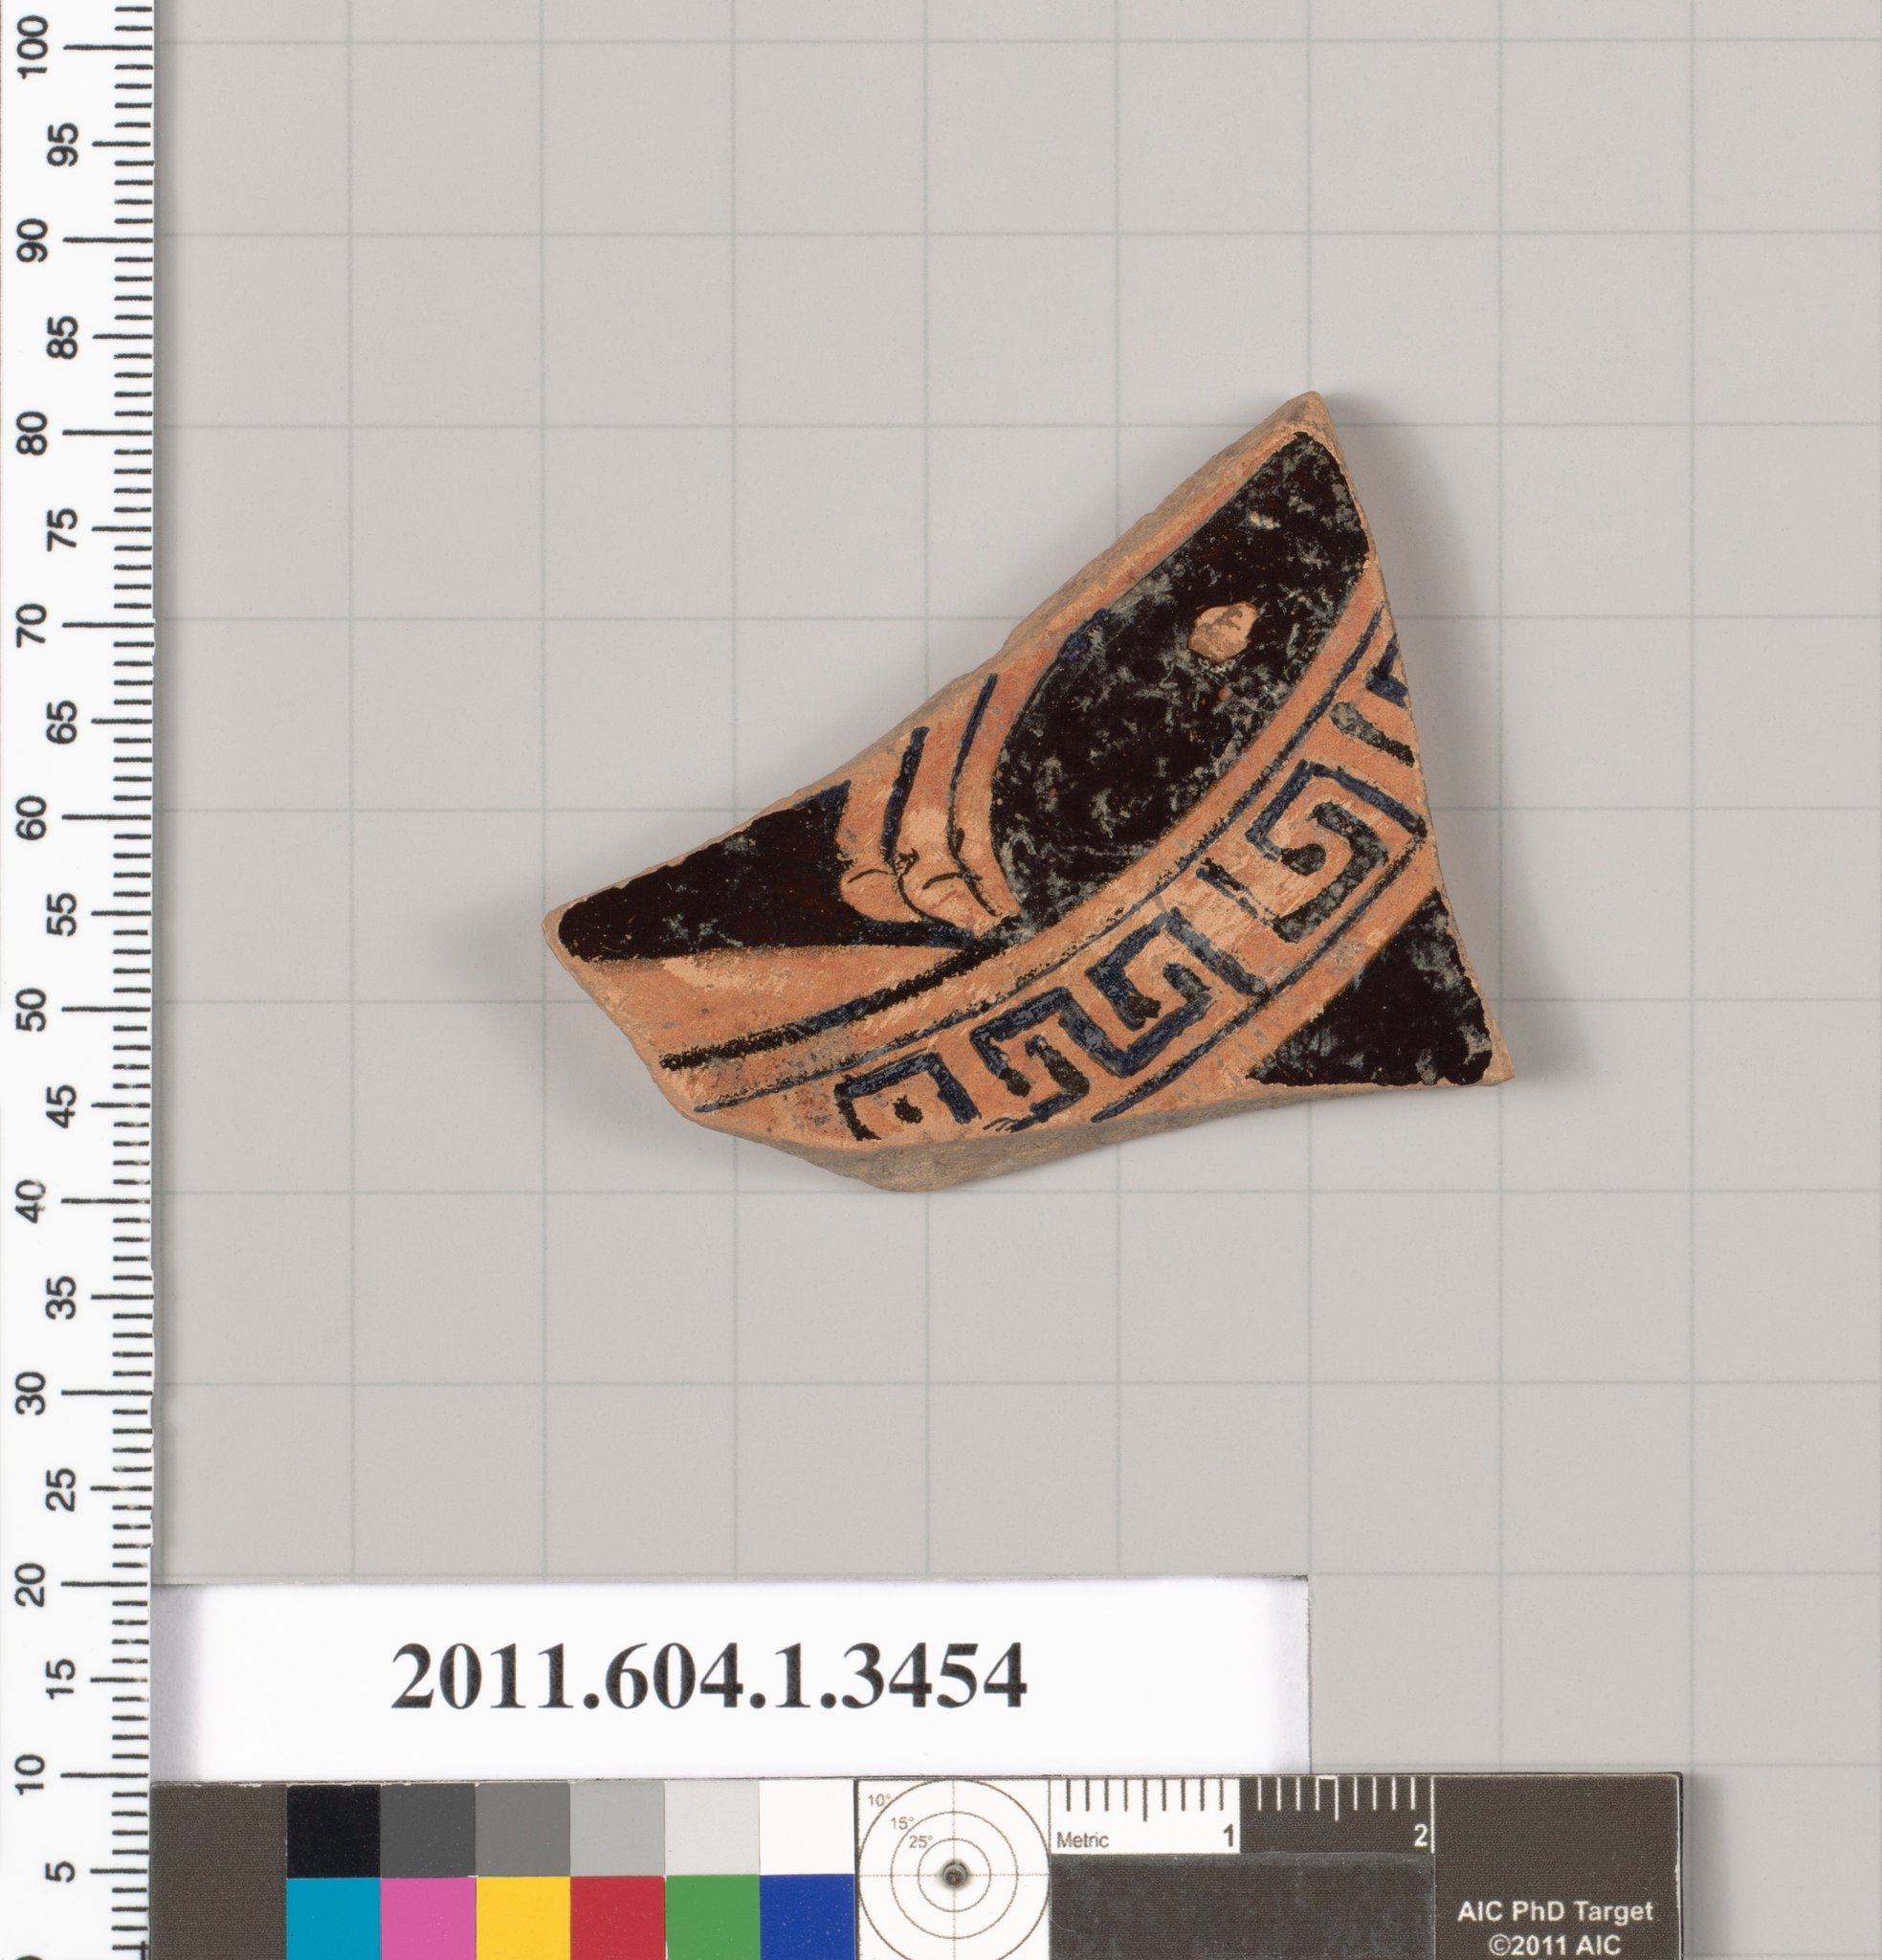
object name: kylix fragment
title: Terracotta fragment of a kylix (drinking cup)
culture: greek, attic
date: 475-451 BCE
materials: terracotta